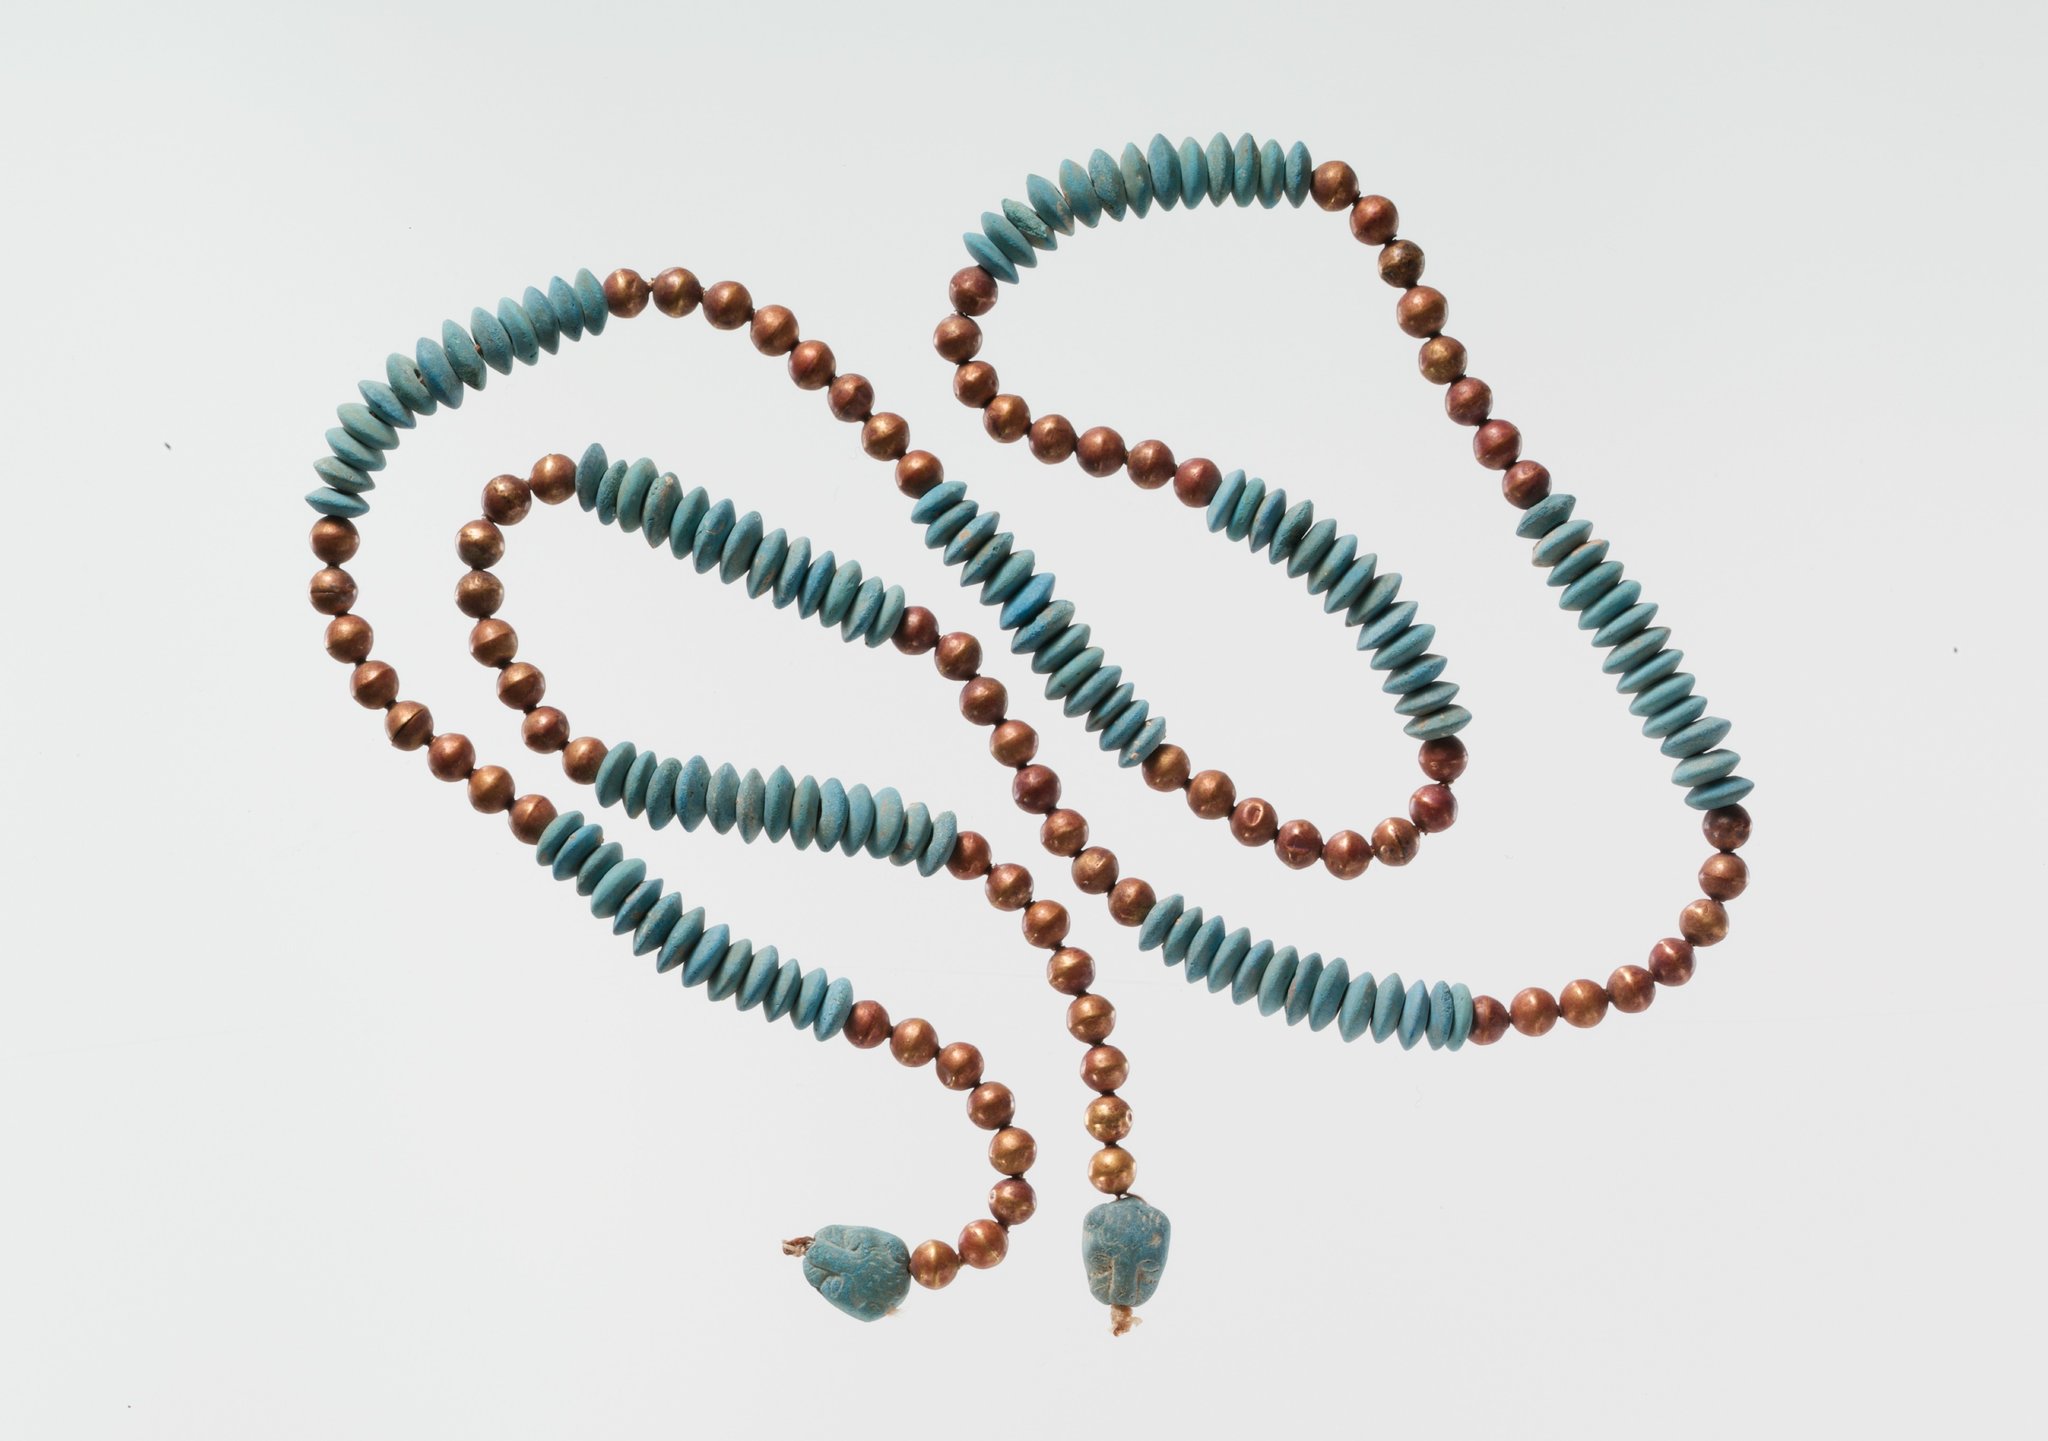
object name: necklace, bead, amulet, feline head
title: String of Beads with Feline-head Amulets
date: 1550-1425 BCE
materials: gold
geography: egypt